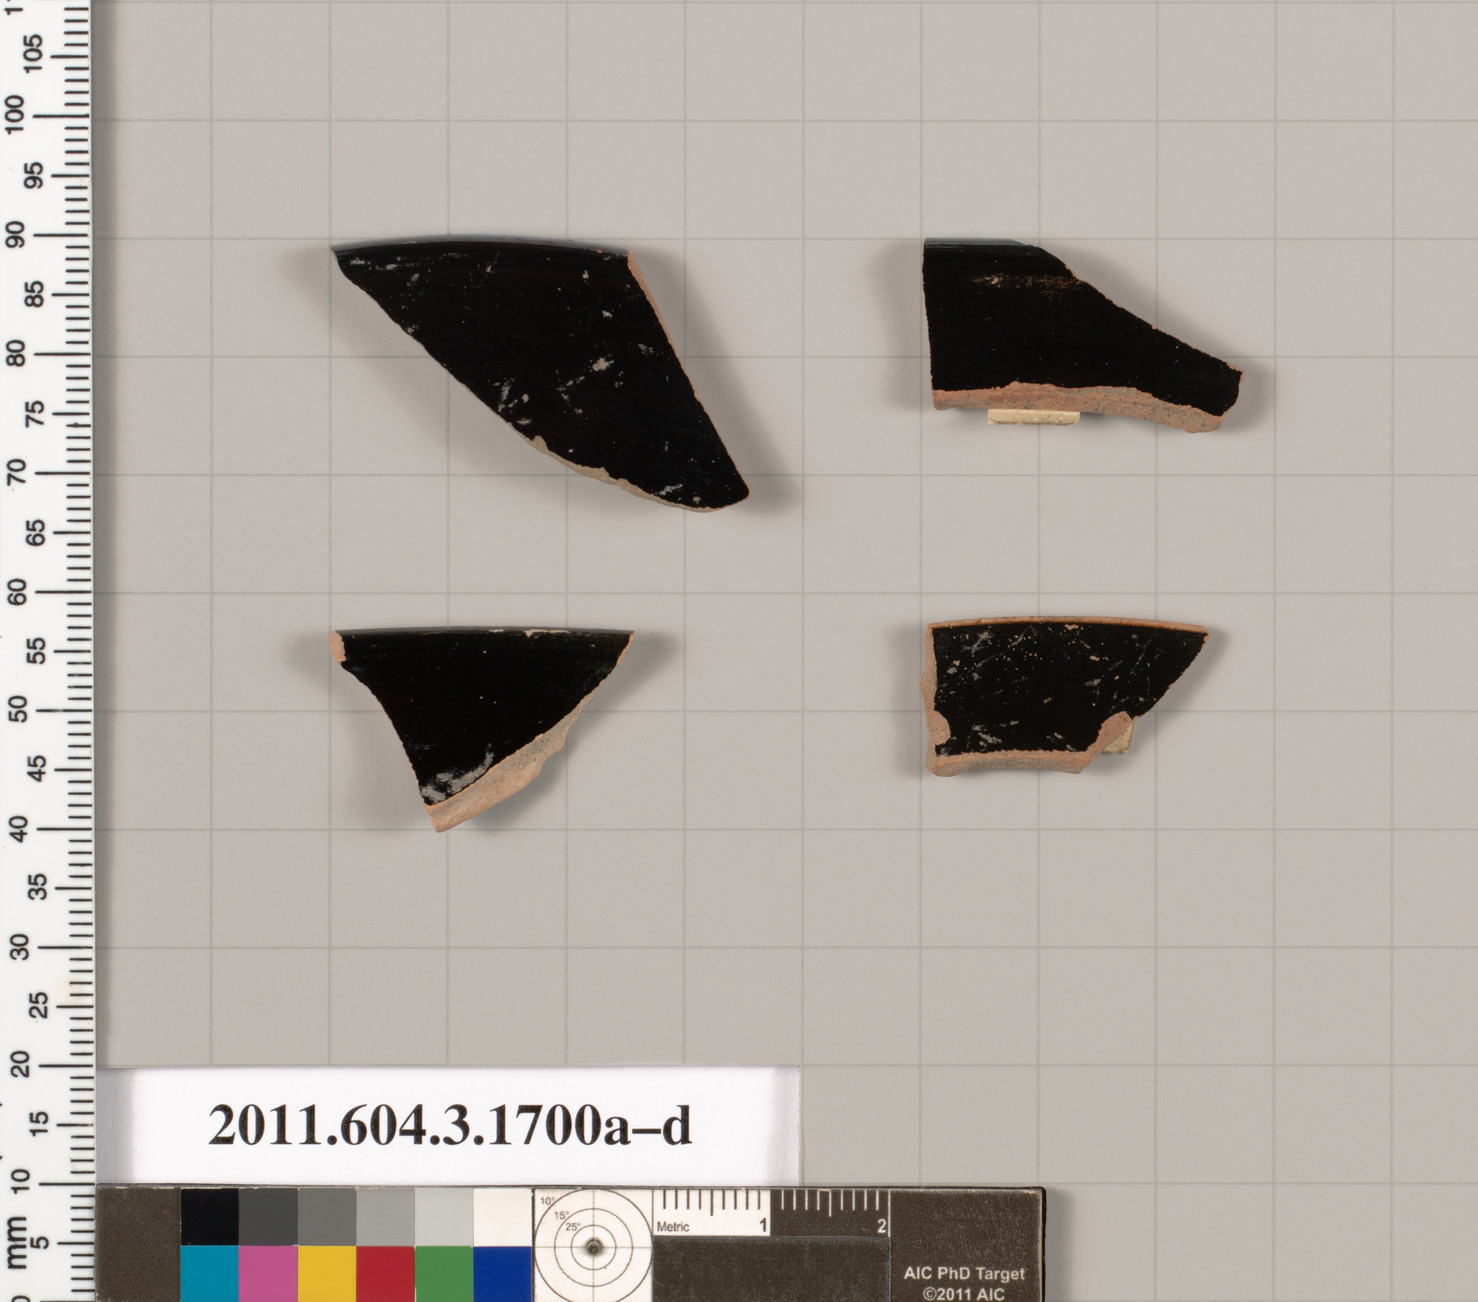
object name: kylix fragment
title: Terracotta rim fragments of kylikes: Band cups (drinking cups)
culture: greek, attic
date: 550-526 BCE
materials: terracotta